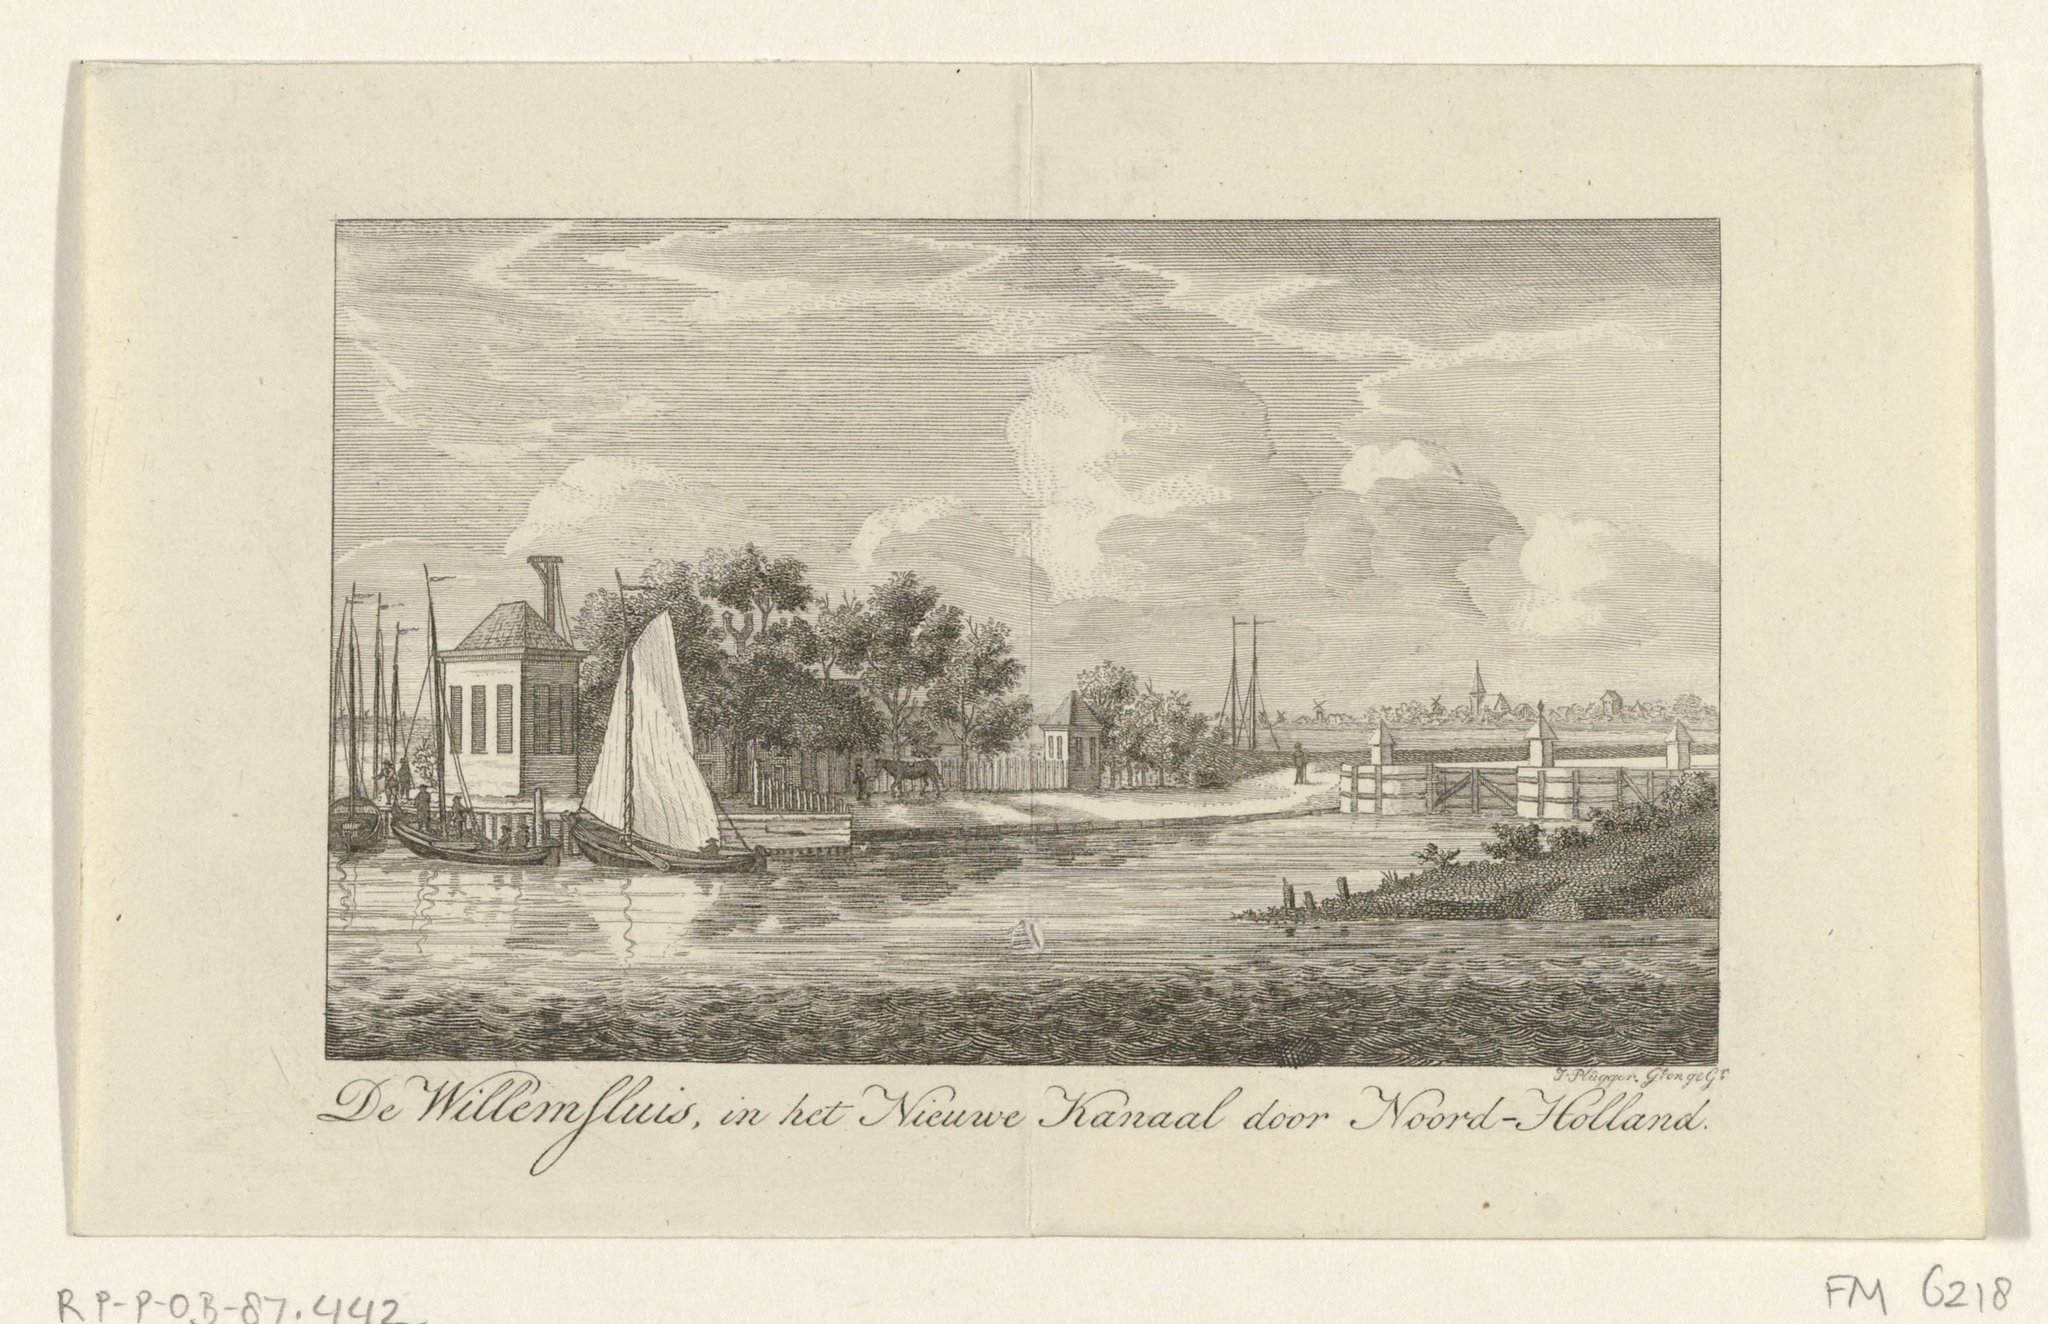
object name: print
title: Willemsluis in het Noord-Hollandsch Kanaal, 1824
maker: jacob plügger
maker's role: print maker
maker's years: 1795-1871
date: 1823-1824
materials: paper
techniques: engraving, etching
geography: netherlands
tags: sluice, weir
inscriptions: collector's mark: Lugt 2228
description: Gebruikt als illustratie in: Amsterdamsche Almanak, tot nut en vermaak. Amsterdam: gebroeders van Arum, 1823.